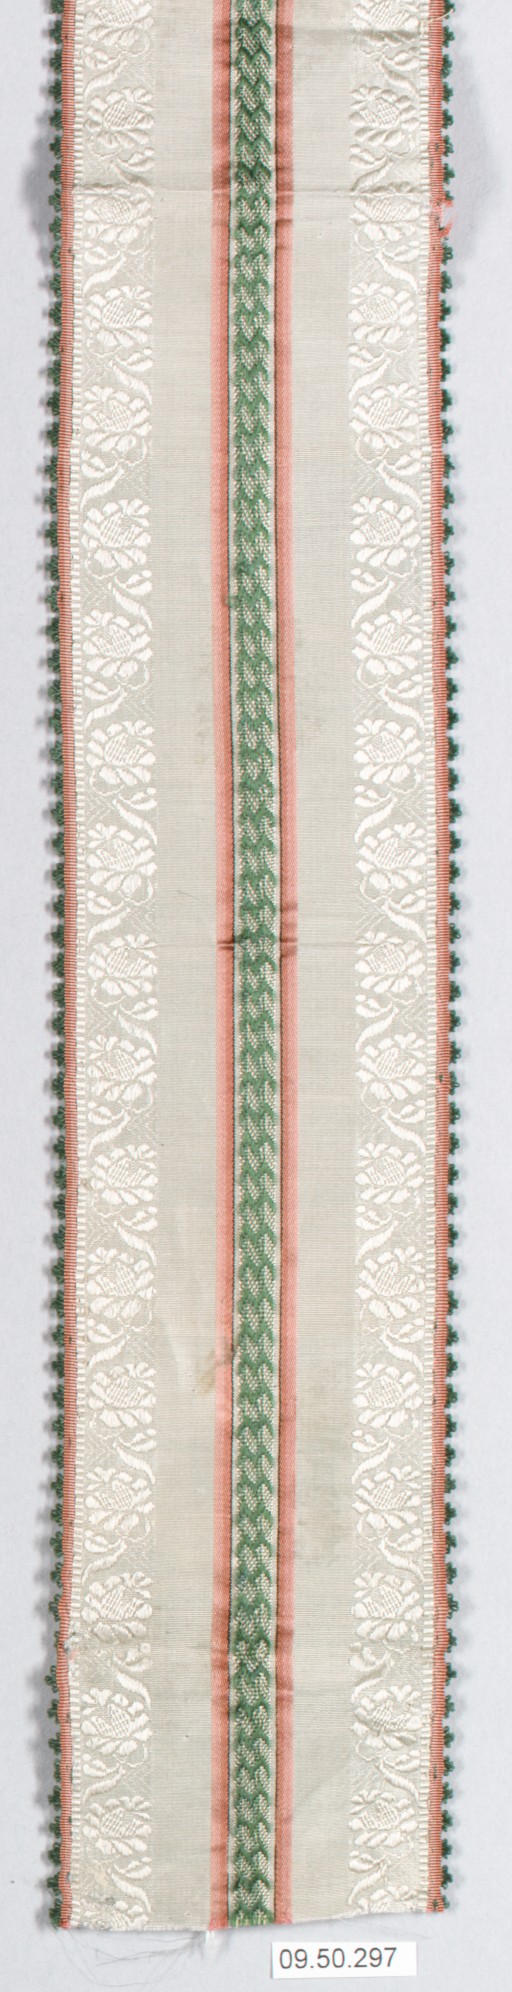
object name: ribbon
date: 1701-1800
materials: silk